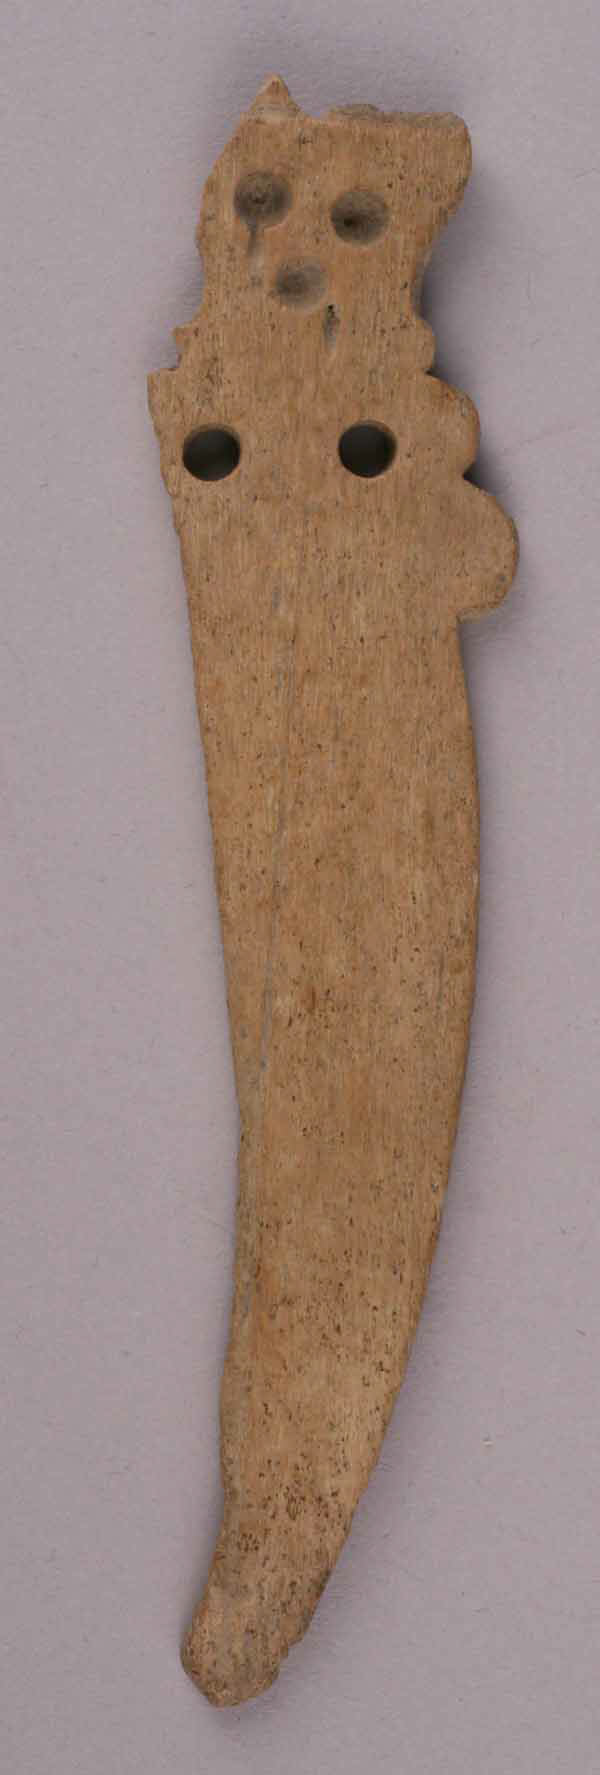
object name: handle or ornament or tool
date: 801-1000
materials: bone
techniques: carving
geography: iran